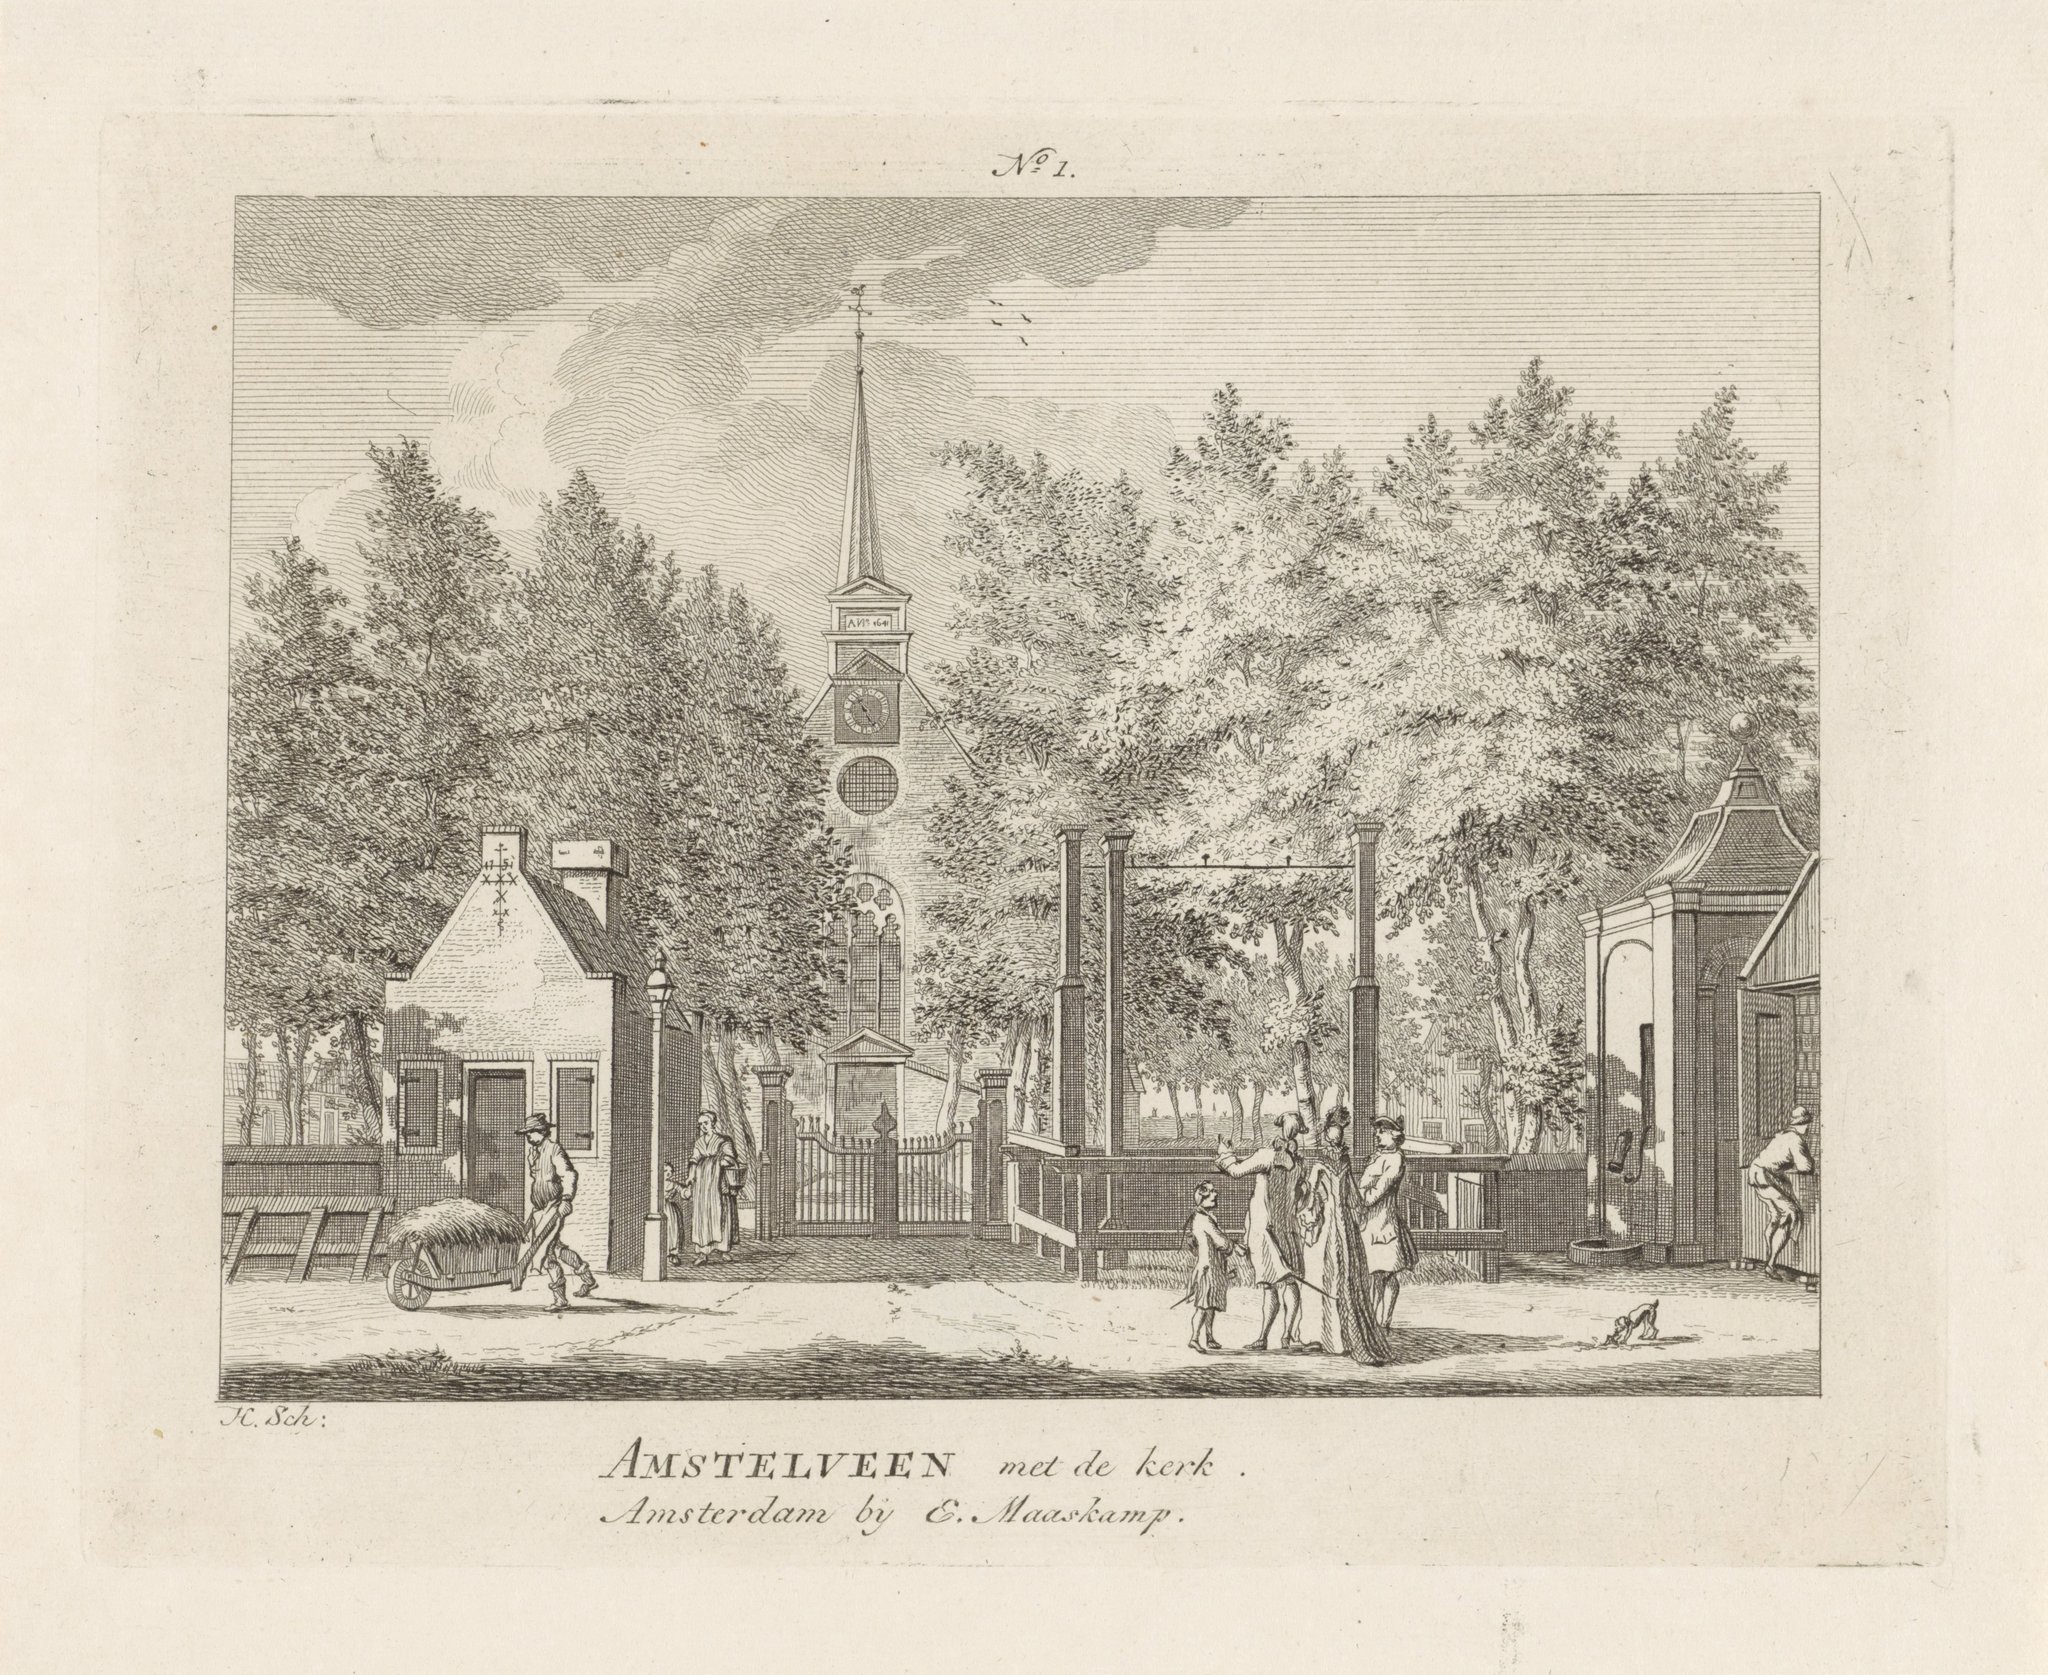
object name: print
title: Amstelveen met de kerk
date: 1795-1805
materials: paper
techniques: etching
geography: amsterdam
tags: amstelveen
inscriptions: collector's mark: Lugt 2228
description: Prent komt voor in Gezichten voorname hollandse dorpen. Amsterdam: E. Maaskamp, ca. 1800.